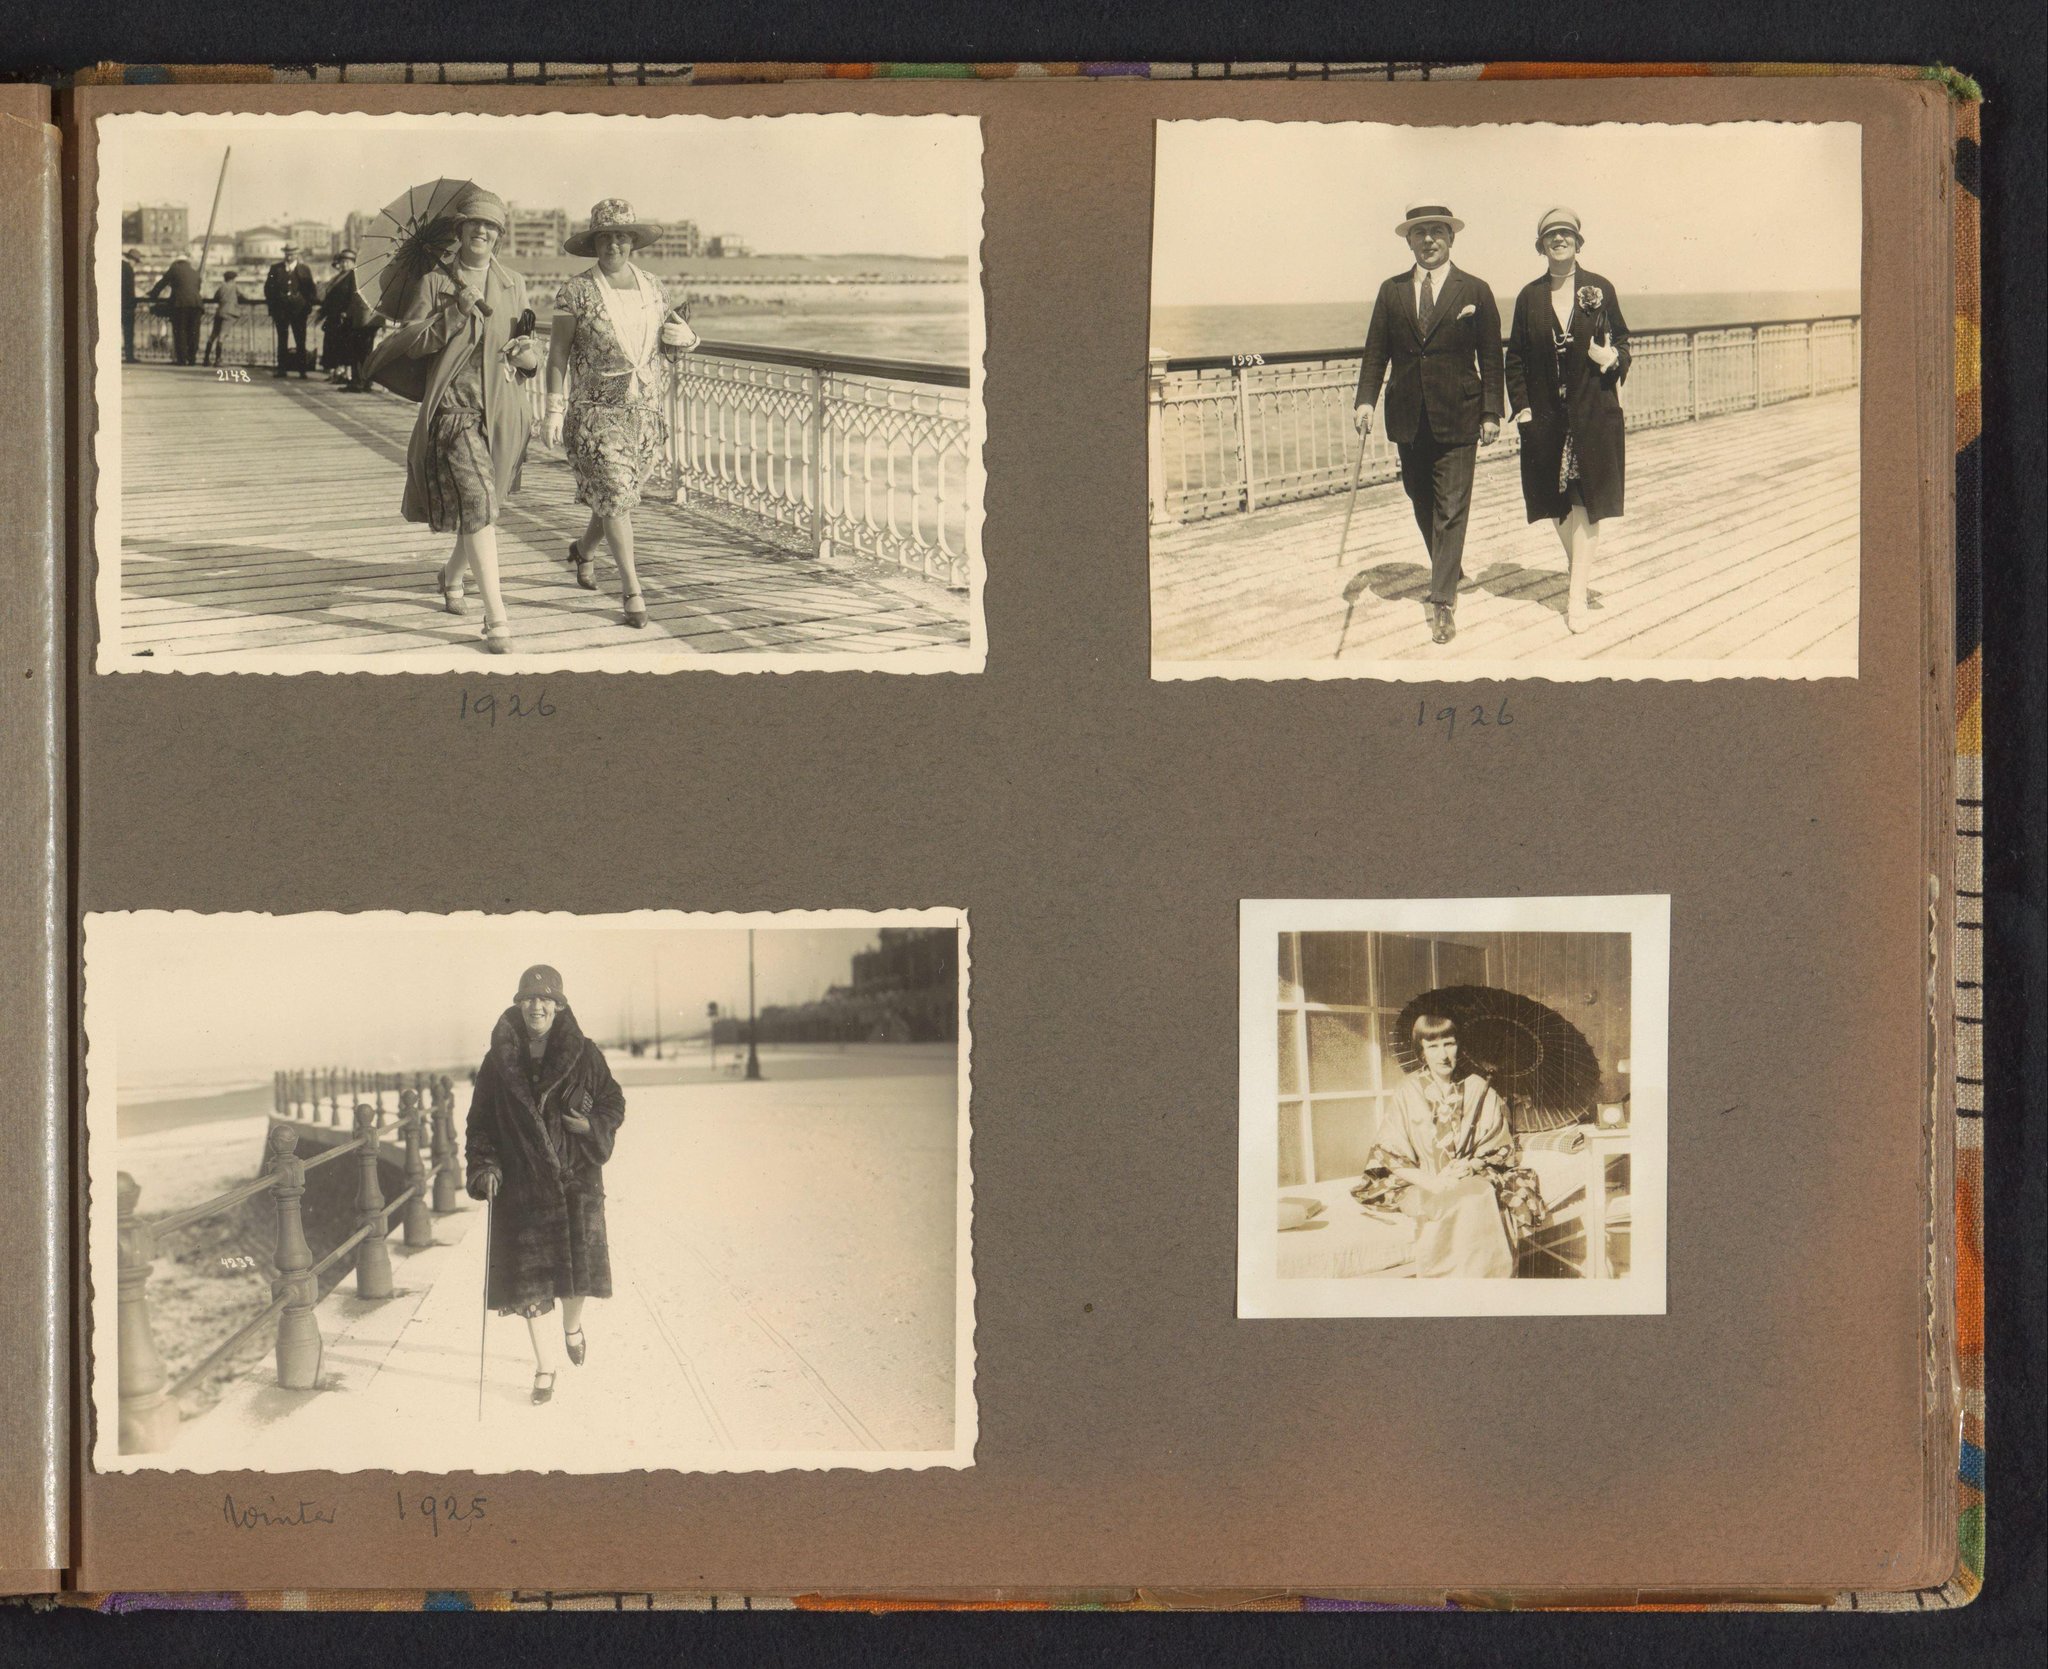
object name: photograph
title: Wandelaars in Scheveningen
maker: Anonymous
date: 1925-1926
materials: cardboard, photographic support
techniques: gelatin silver print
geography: scheveningen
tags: adult woman, strolling, adult man, pier, quay, wharf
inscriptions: number: ‘2148’, number: ‘4232’, number: ‘1998’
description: Albumblad met foto's van mensen op de pier en de boulevard van Scheveningen. Ook een foto van een vrouw met een parasol en een wijd gewaad. Onderdeel van Fotoalbum van een onbekende Nederlandse familie met connecties in Suriname en Nederlands-Indië (2).